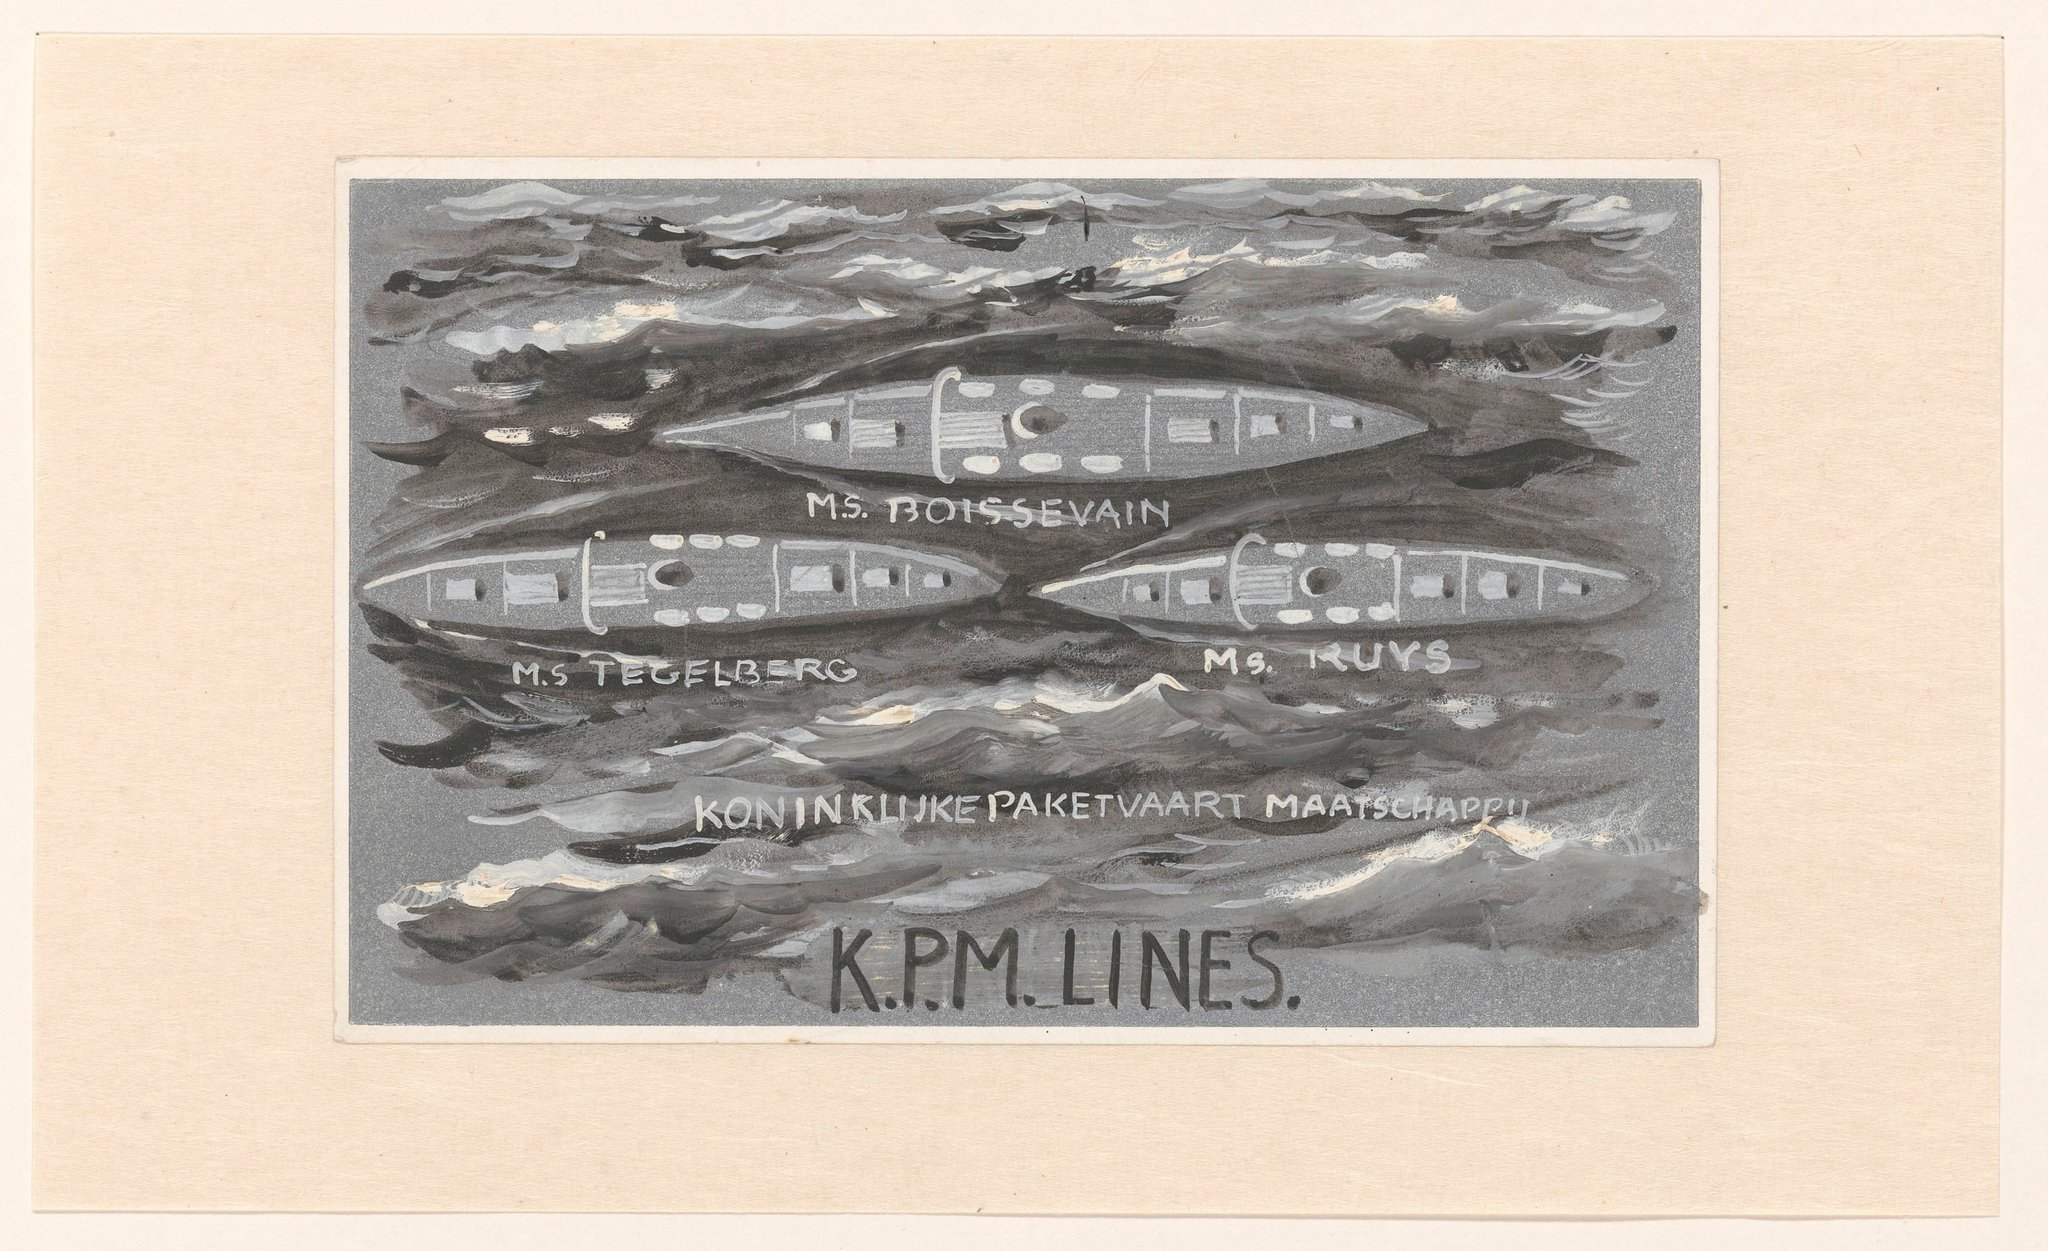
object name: drawing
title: Ontwerp voor vignet van de Koninklijke Paketvaart Maatschappij, K.P.M. Lines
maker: carel adolph lion cachet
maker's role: draughtsman, print maker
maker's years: 1864-1945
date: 1874-1945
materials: paper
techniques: brush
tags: names of organizations, companies, trade unions, etc., advertisement, notice, ships (in general) - cc - more than one ship